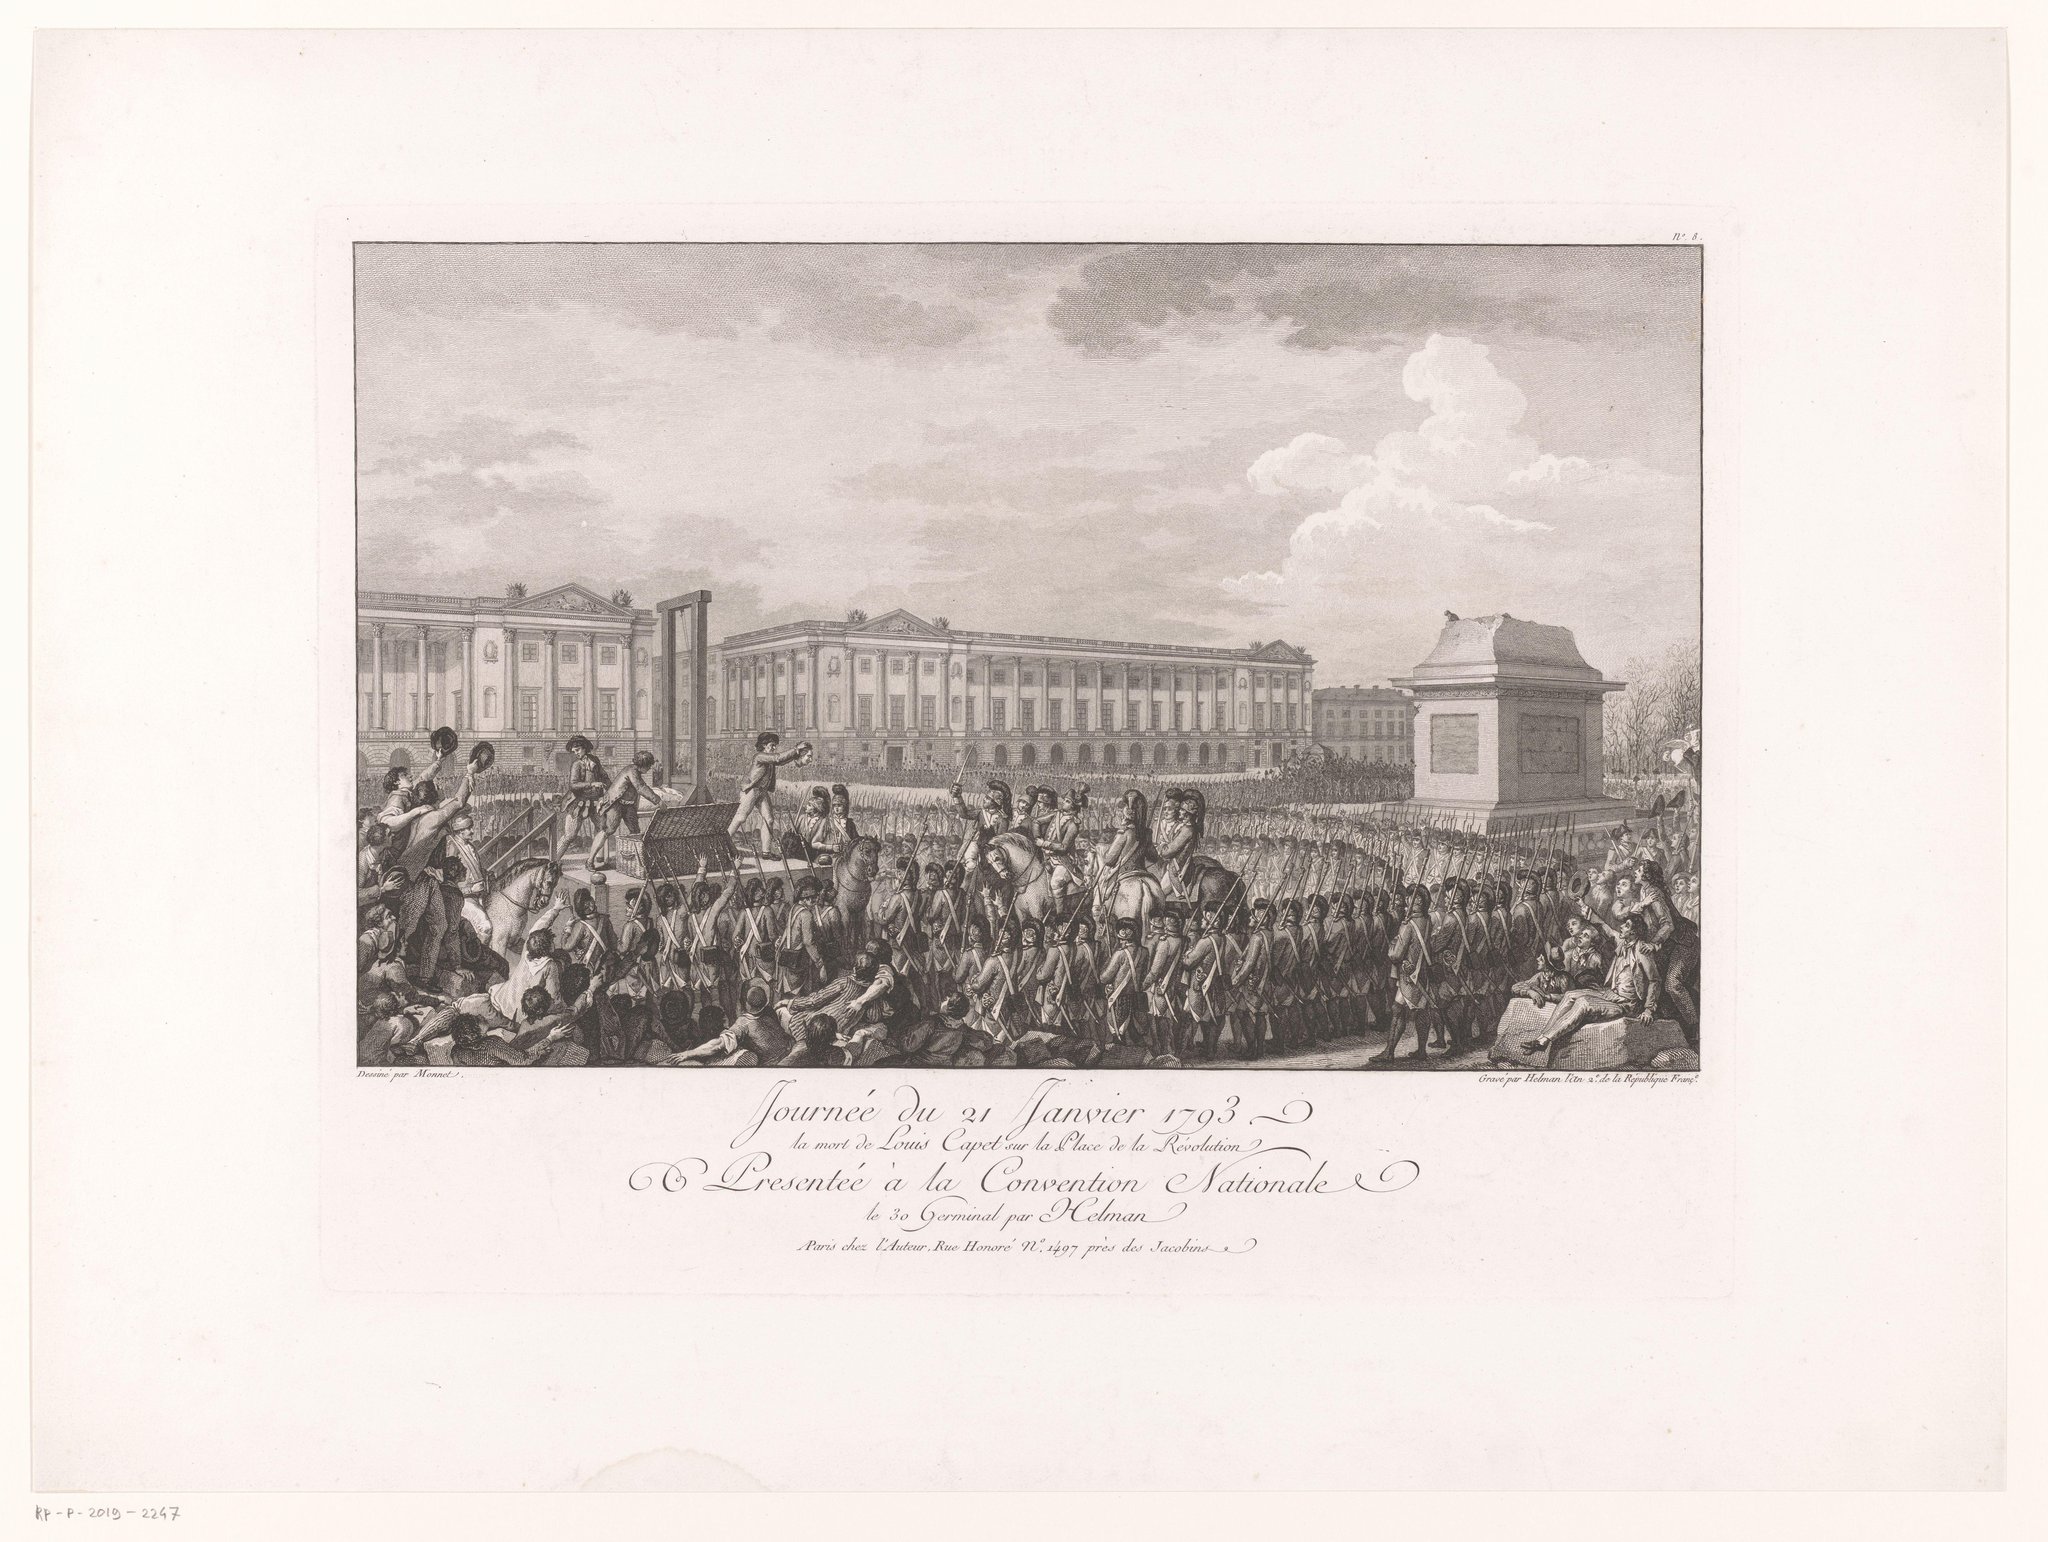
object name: print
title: Eerste dagen van de Franse Revolutie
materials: paper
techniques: engraving, etching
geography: france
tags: paris, lodewijk xvi (koning van frankrijk), violent death ~ beheading by guillotine, historical persons, on the scaffold or place of execution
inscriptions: collector's mark: Lugt 2228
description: Maakt deel uit van een serie getiteld 'La Révolution française depuis l'ouverture des États géneraux jusquáu 9 Brumaire' met vijftien prenten naar schilderijen met als onderwerp de eerste dagen van de Franse Revolutie. De serie werd verschillende malen uitgegeven, aanvankelijk onder de titel 'Les principales journées de la Révolution'. Voor meer informatie zie IFF 18e siècle, dl. 11, p. 291.